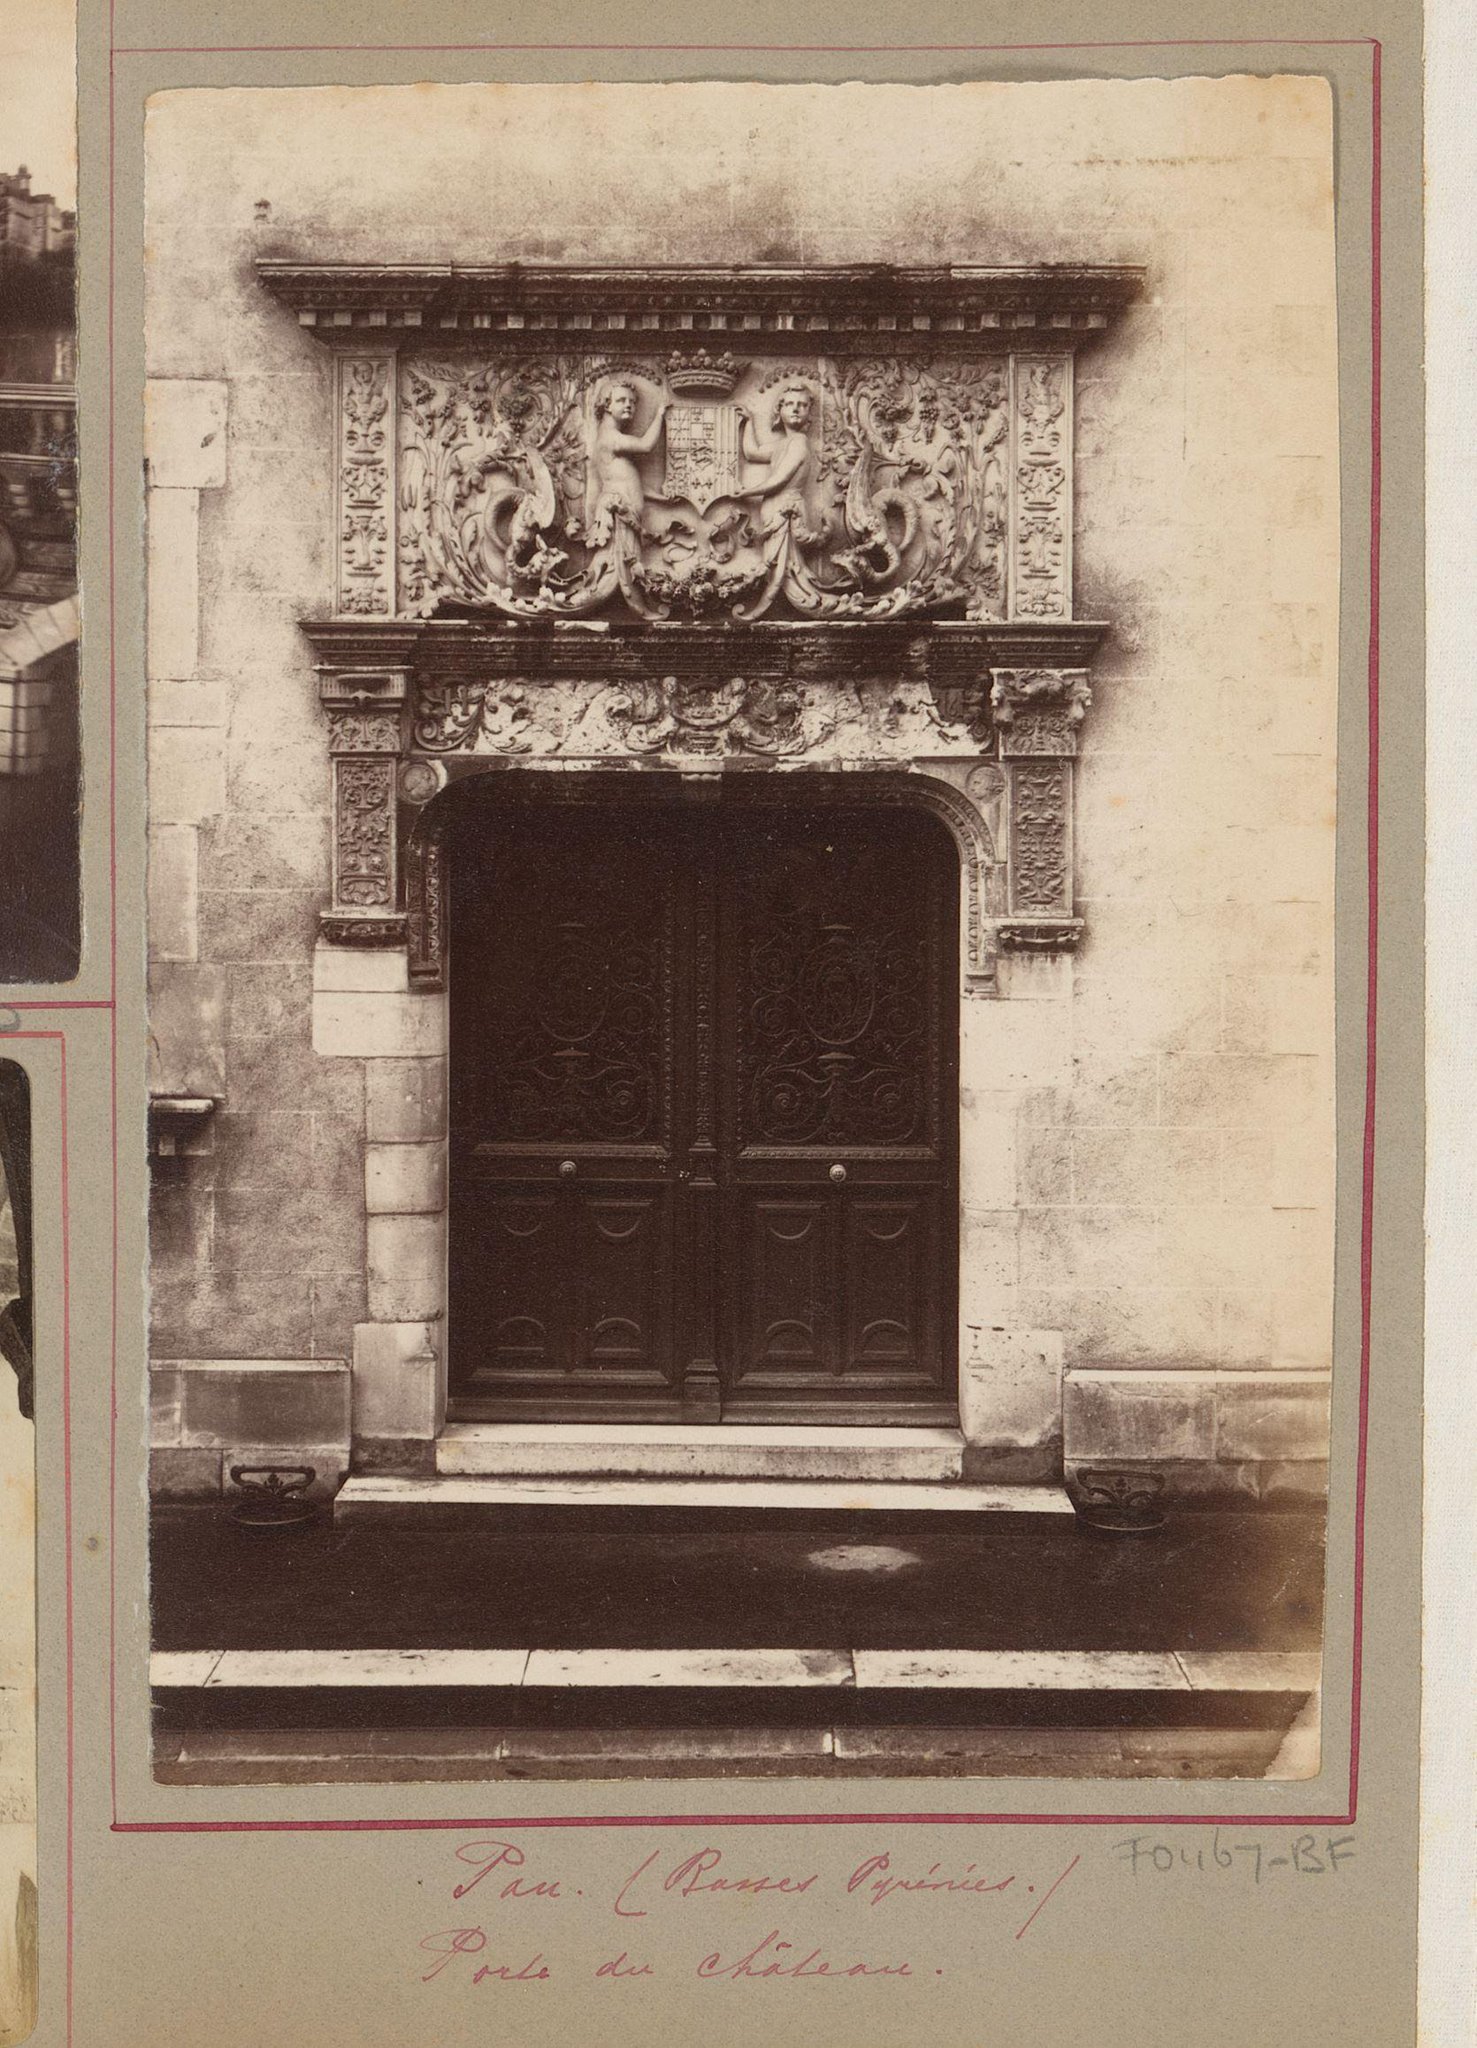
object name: album leaf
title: Entree van Château de Pau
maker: Anonymous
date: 1880-1910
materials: photographic support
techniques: albumen print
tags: castle, gate, entrance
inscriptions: annotation: ‘Pau [...]/ Porte du château’